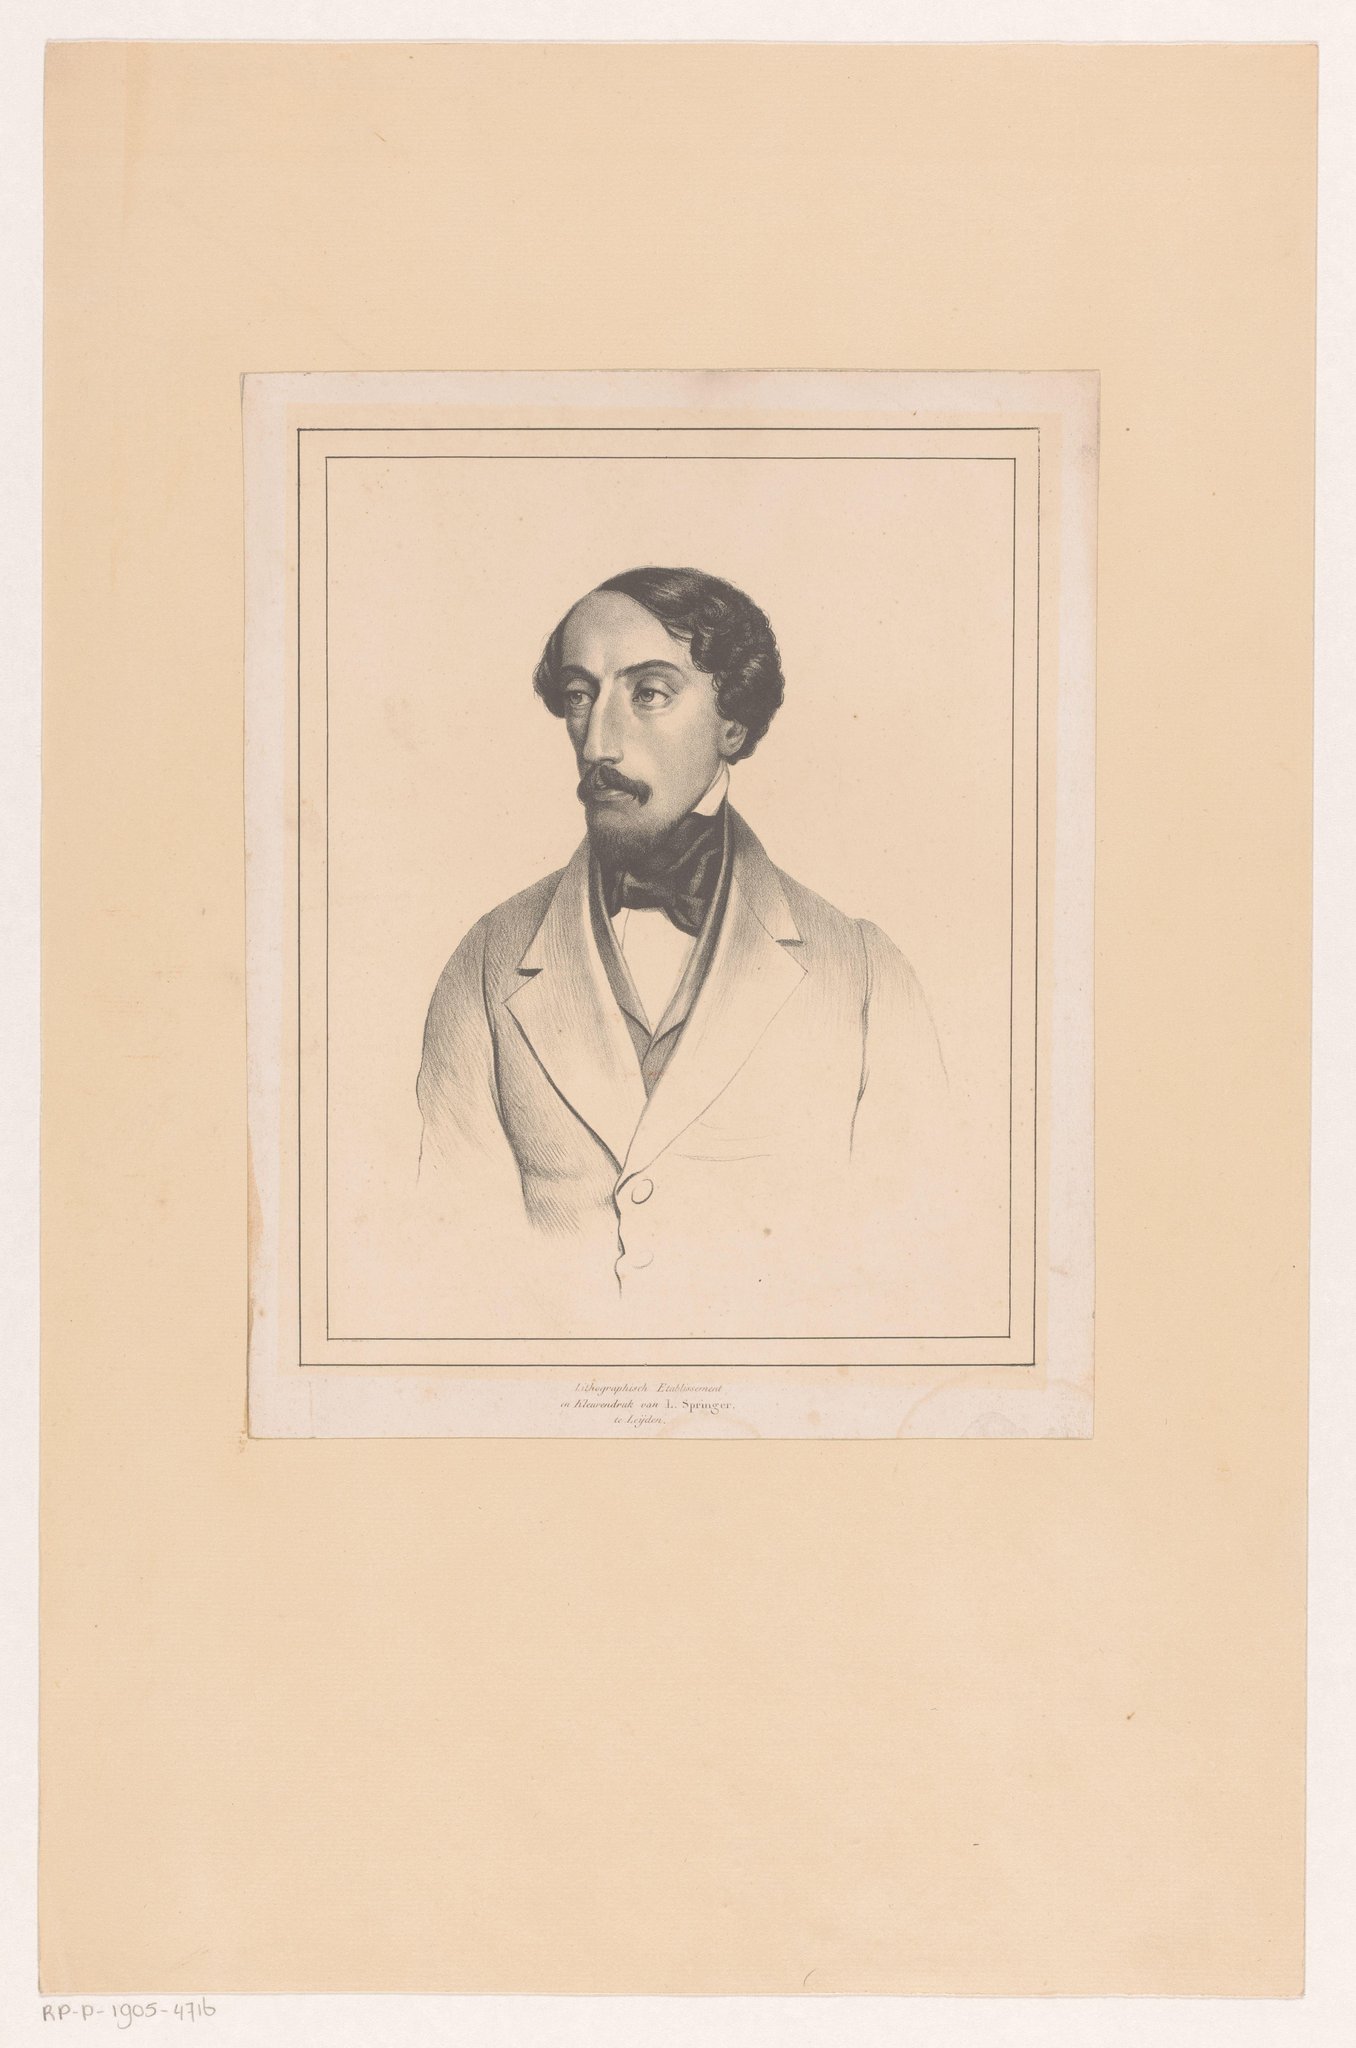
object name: print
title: Portret van onbekende man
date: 1809-1871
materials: paper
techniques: tone lithography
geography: leiden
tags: anonymous historical person portrayed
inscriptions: collector's mark: Lugt 2228